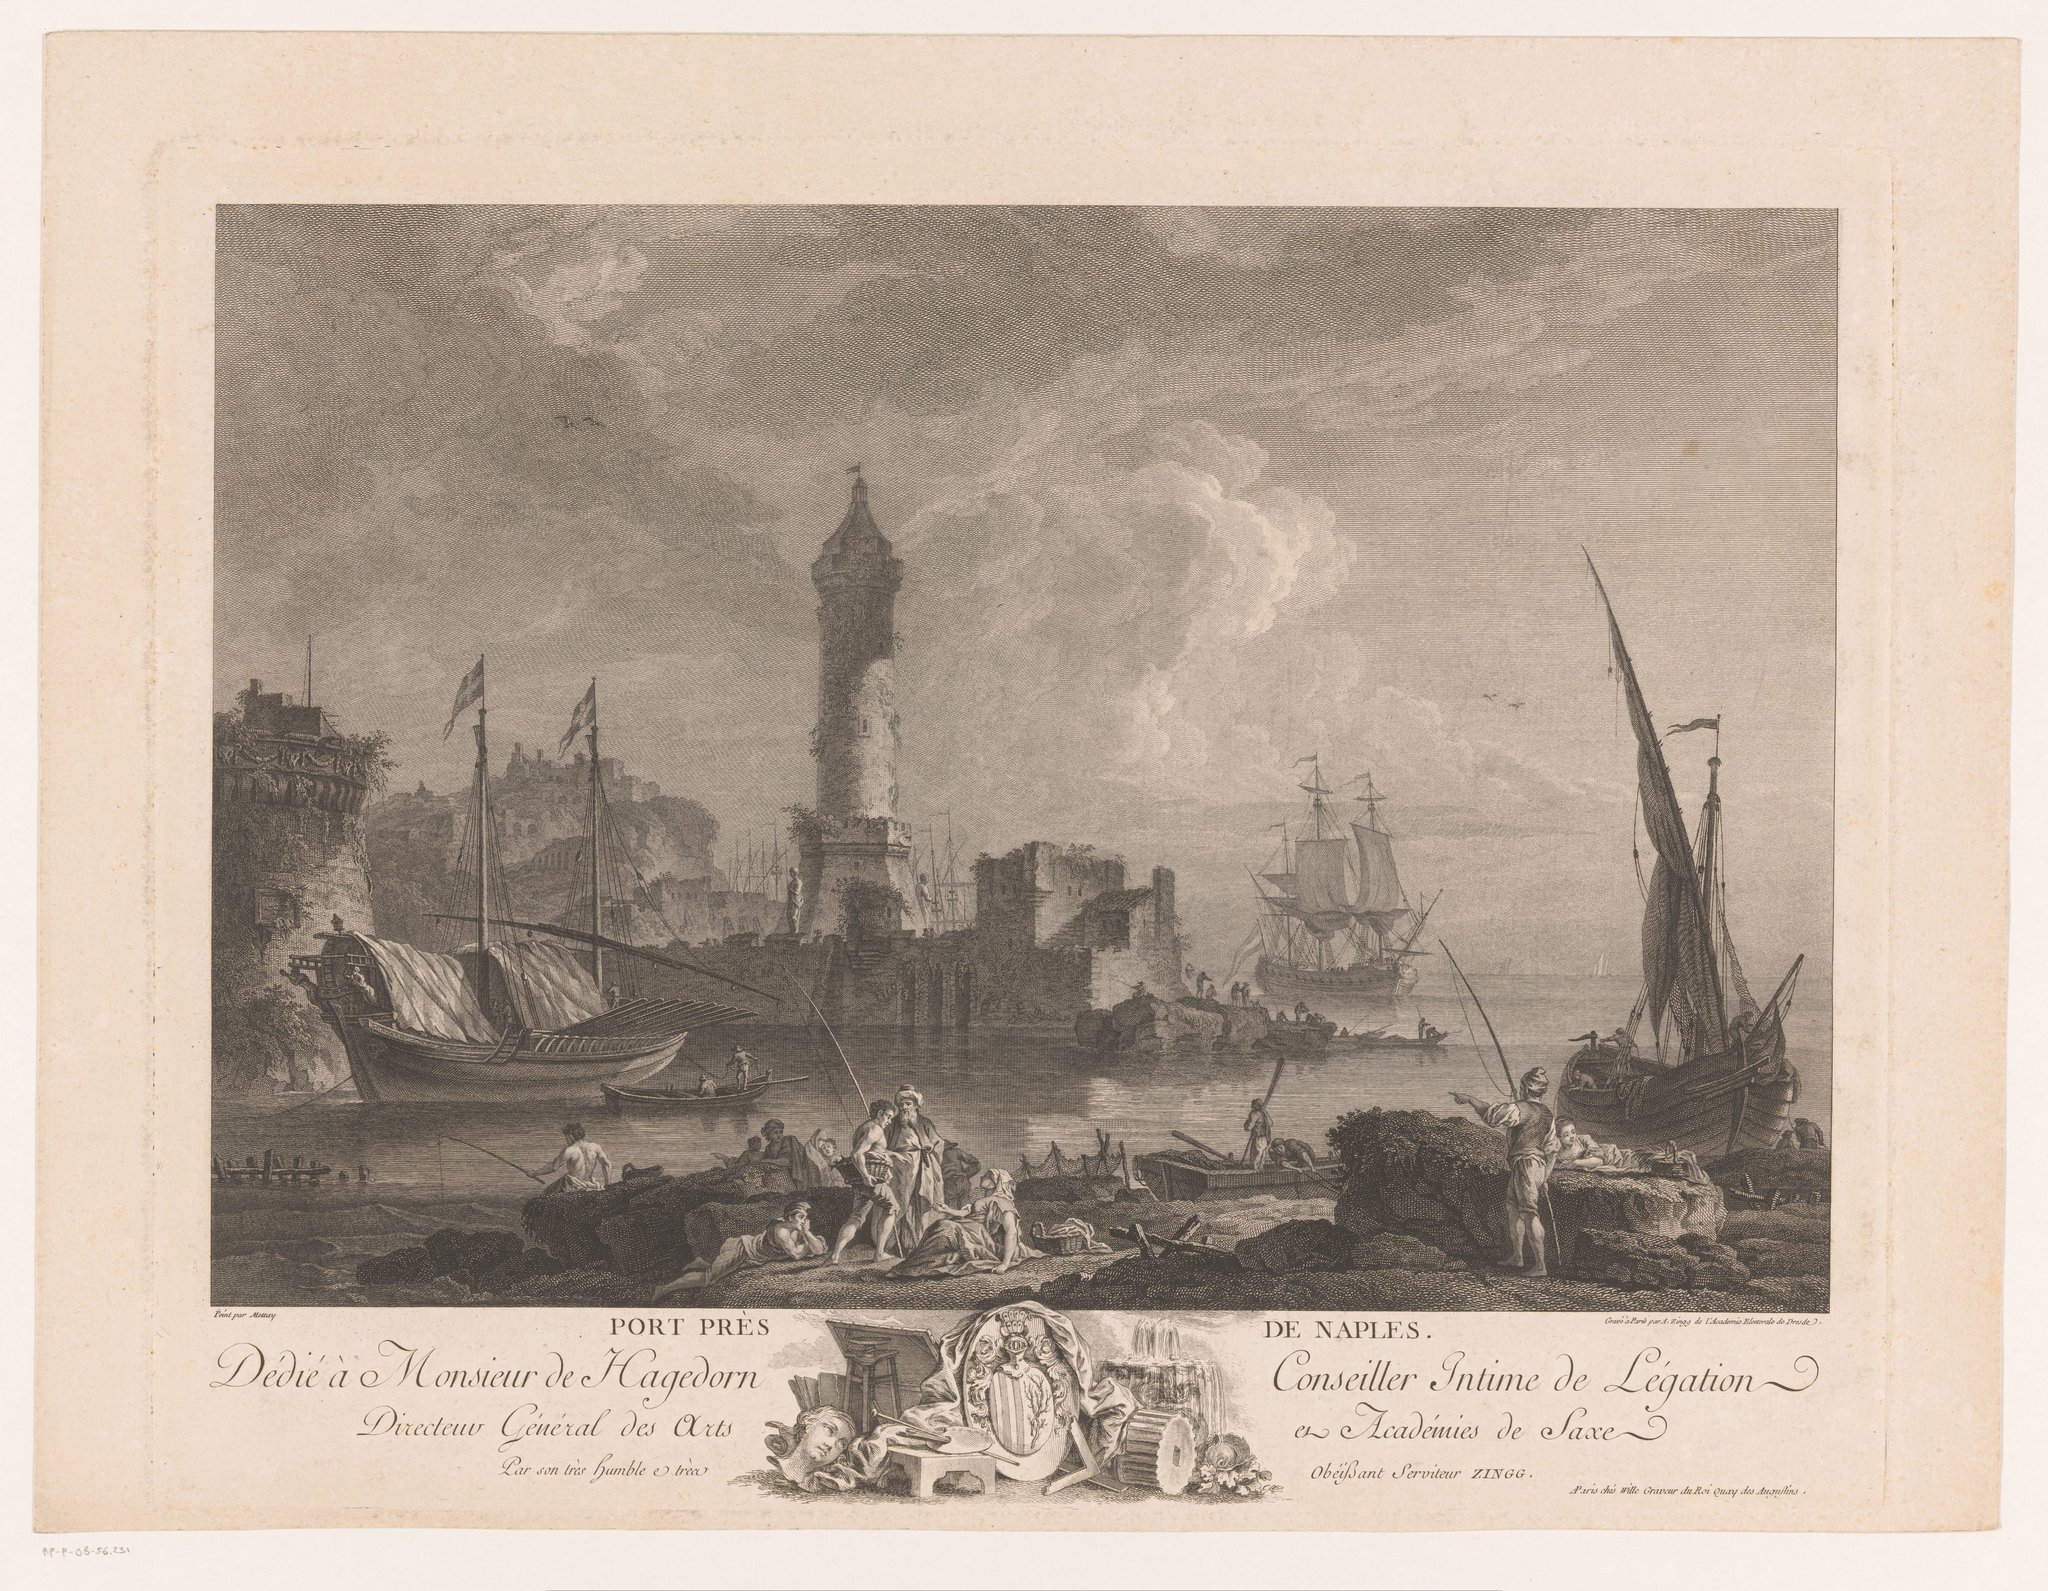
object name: print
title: Haven bij Napels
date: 1744-1808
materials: paper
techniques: engraving, etching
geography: paris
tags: harbour, naples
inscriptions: collector's mark: Lugt 2228